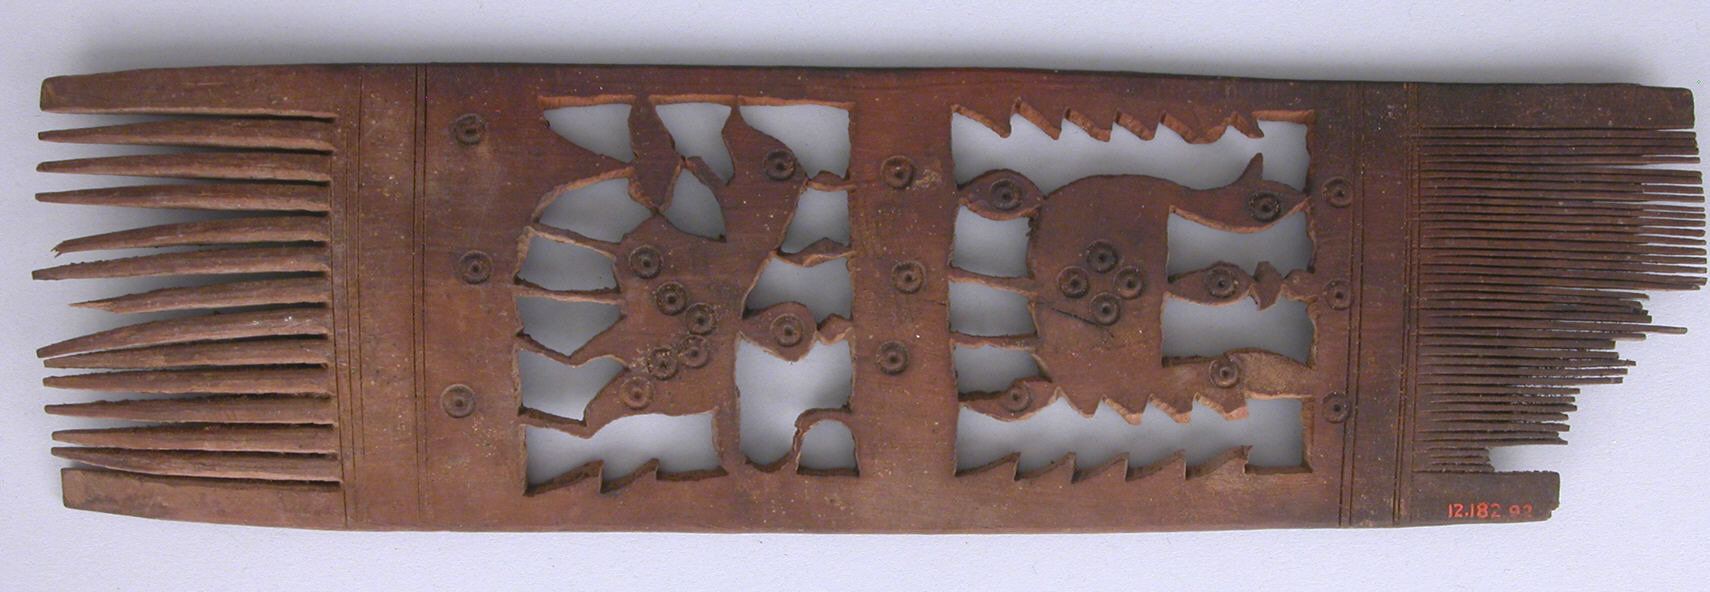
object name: comb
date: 601-800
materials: wood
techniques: carving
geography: egypt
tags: animals